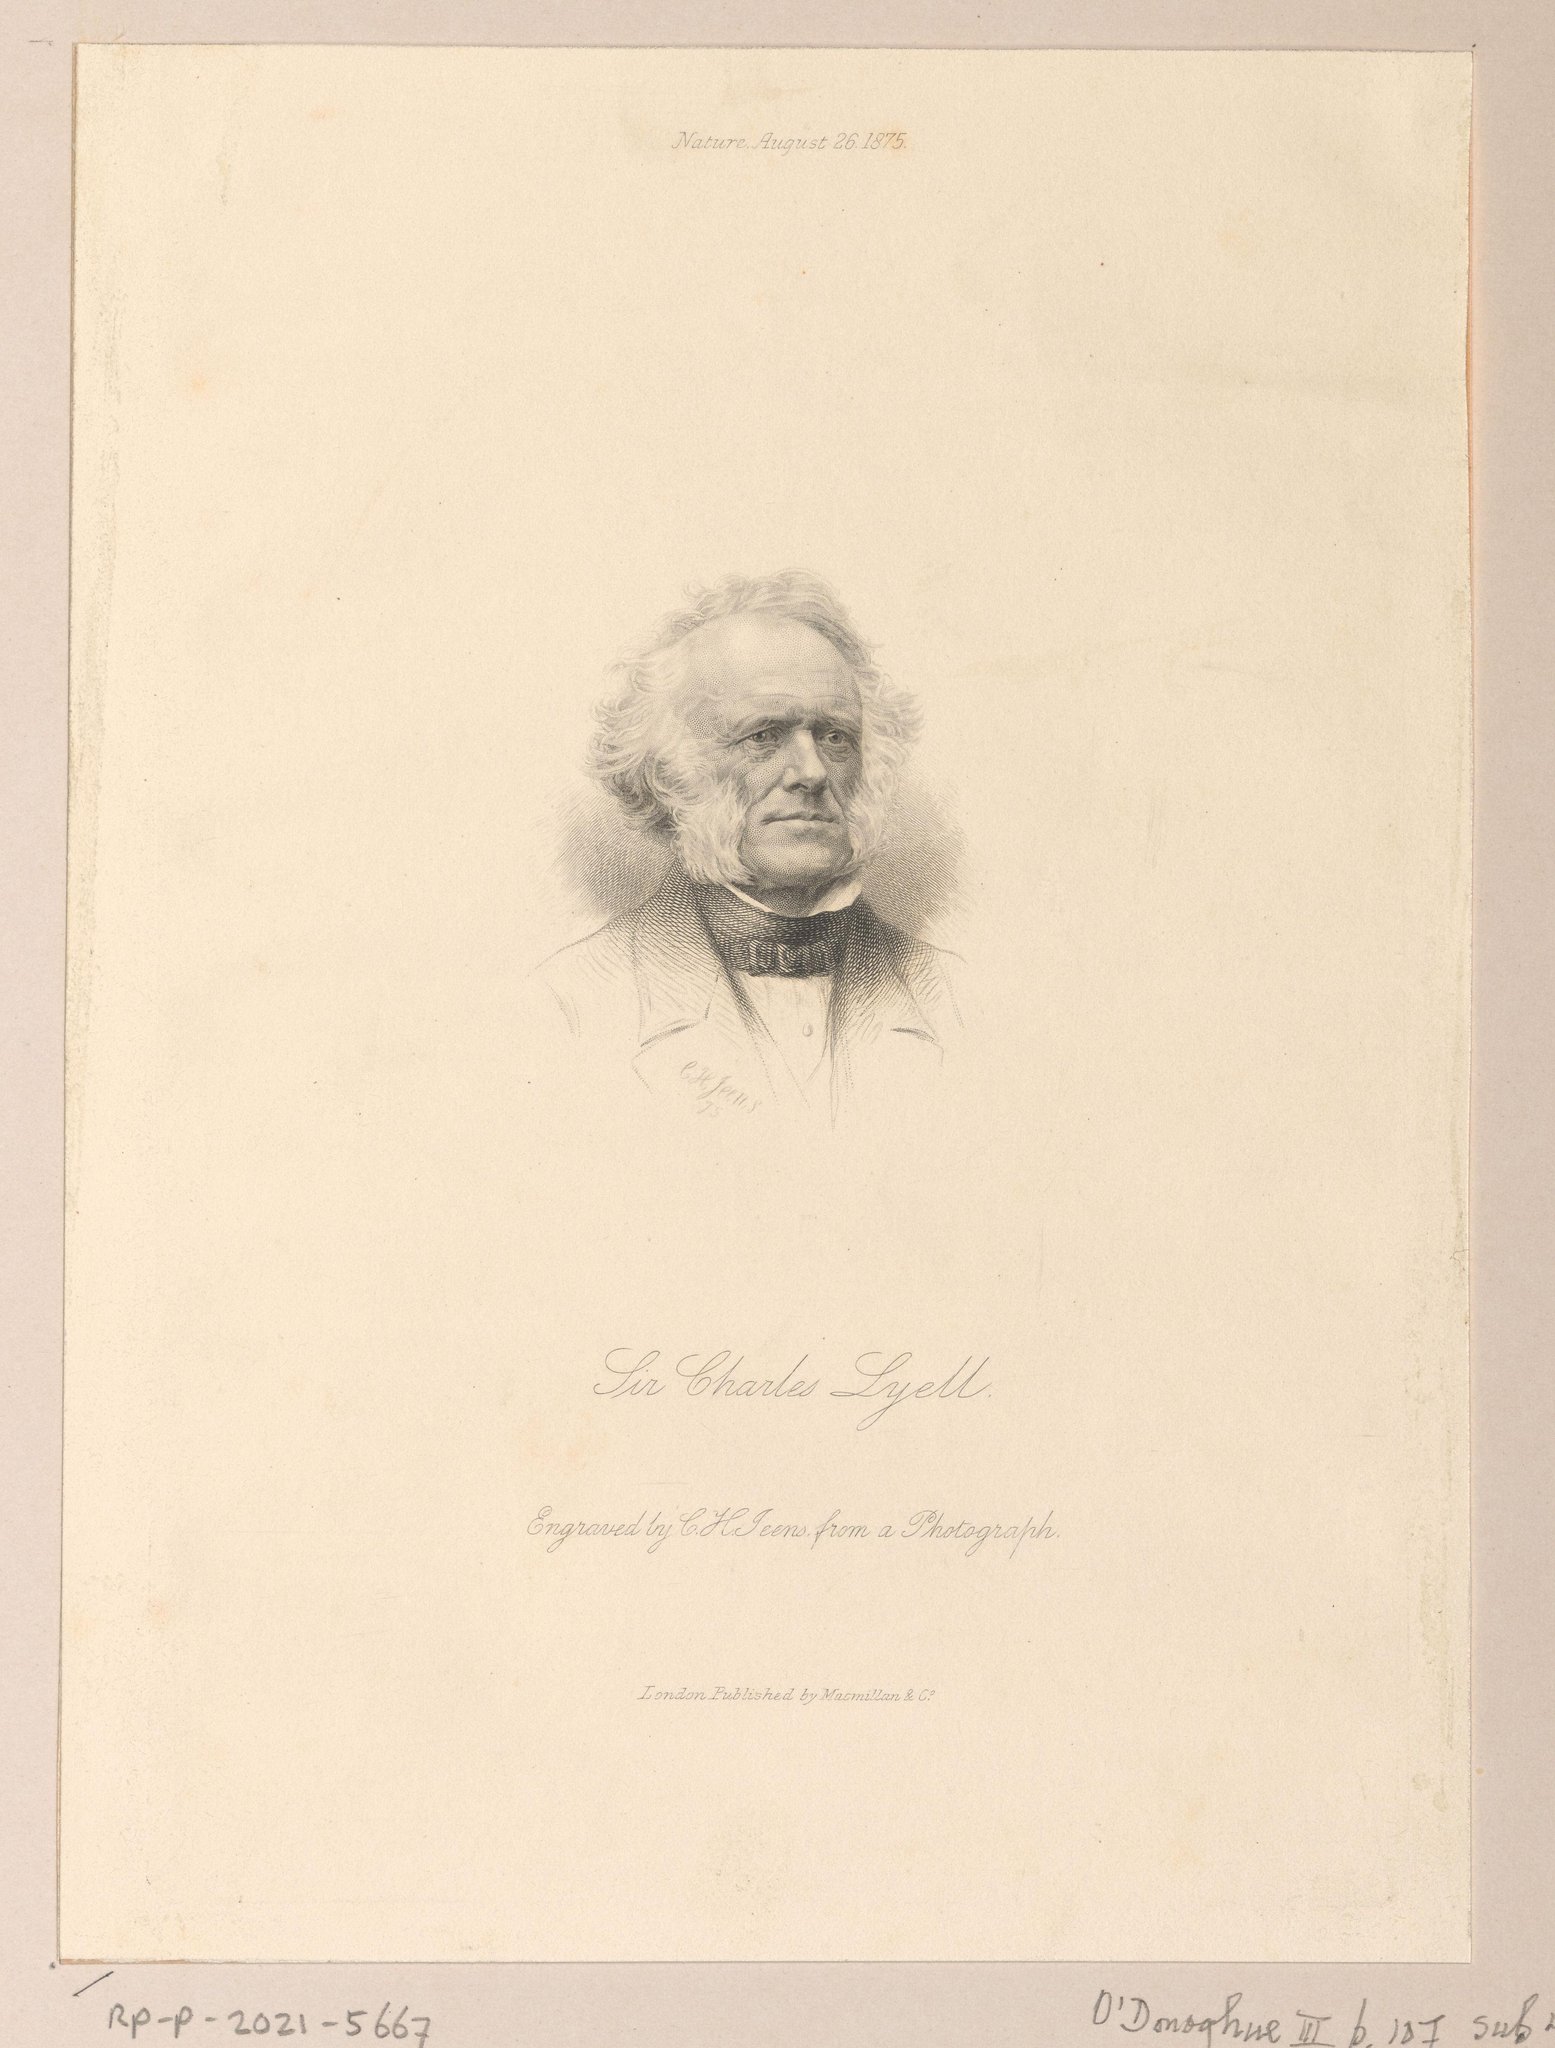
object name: print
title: Portret van Charles Lyell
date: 1875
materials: paper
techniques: engraving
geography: england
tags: historical persons, geology (+ portrait of scholar, scientist)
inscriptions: date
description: Prent uit: Nature, a weekly illustrated journal of science 7 (1875), 26 augustus 1875.